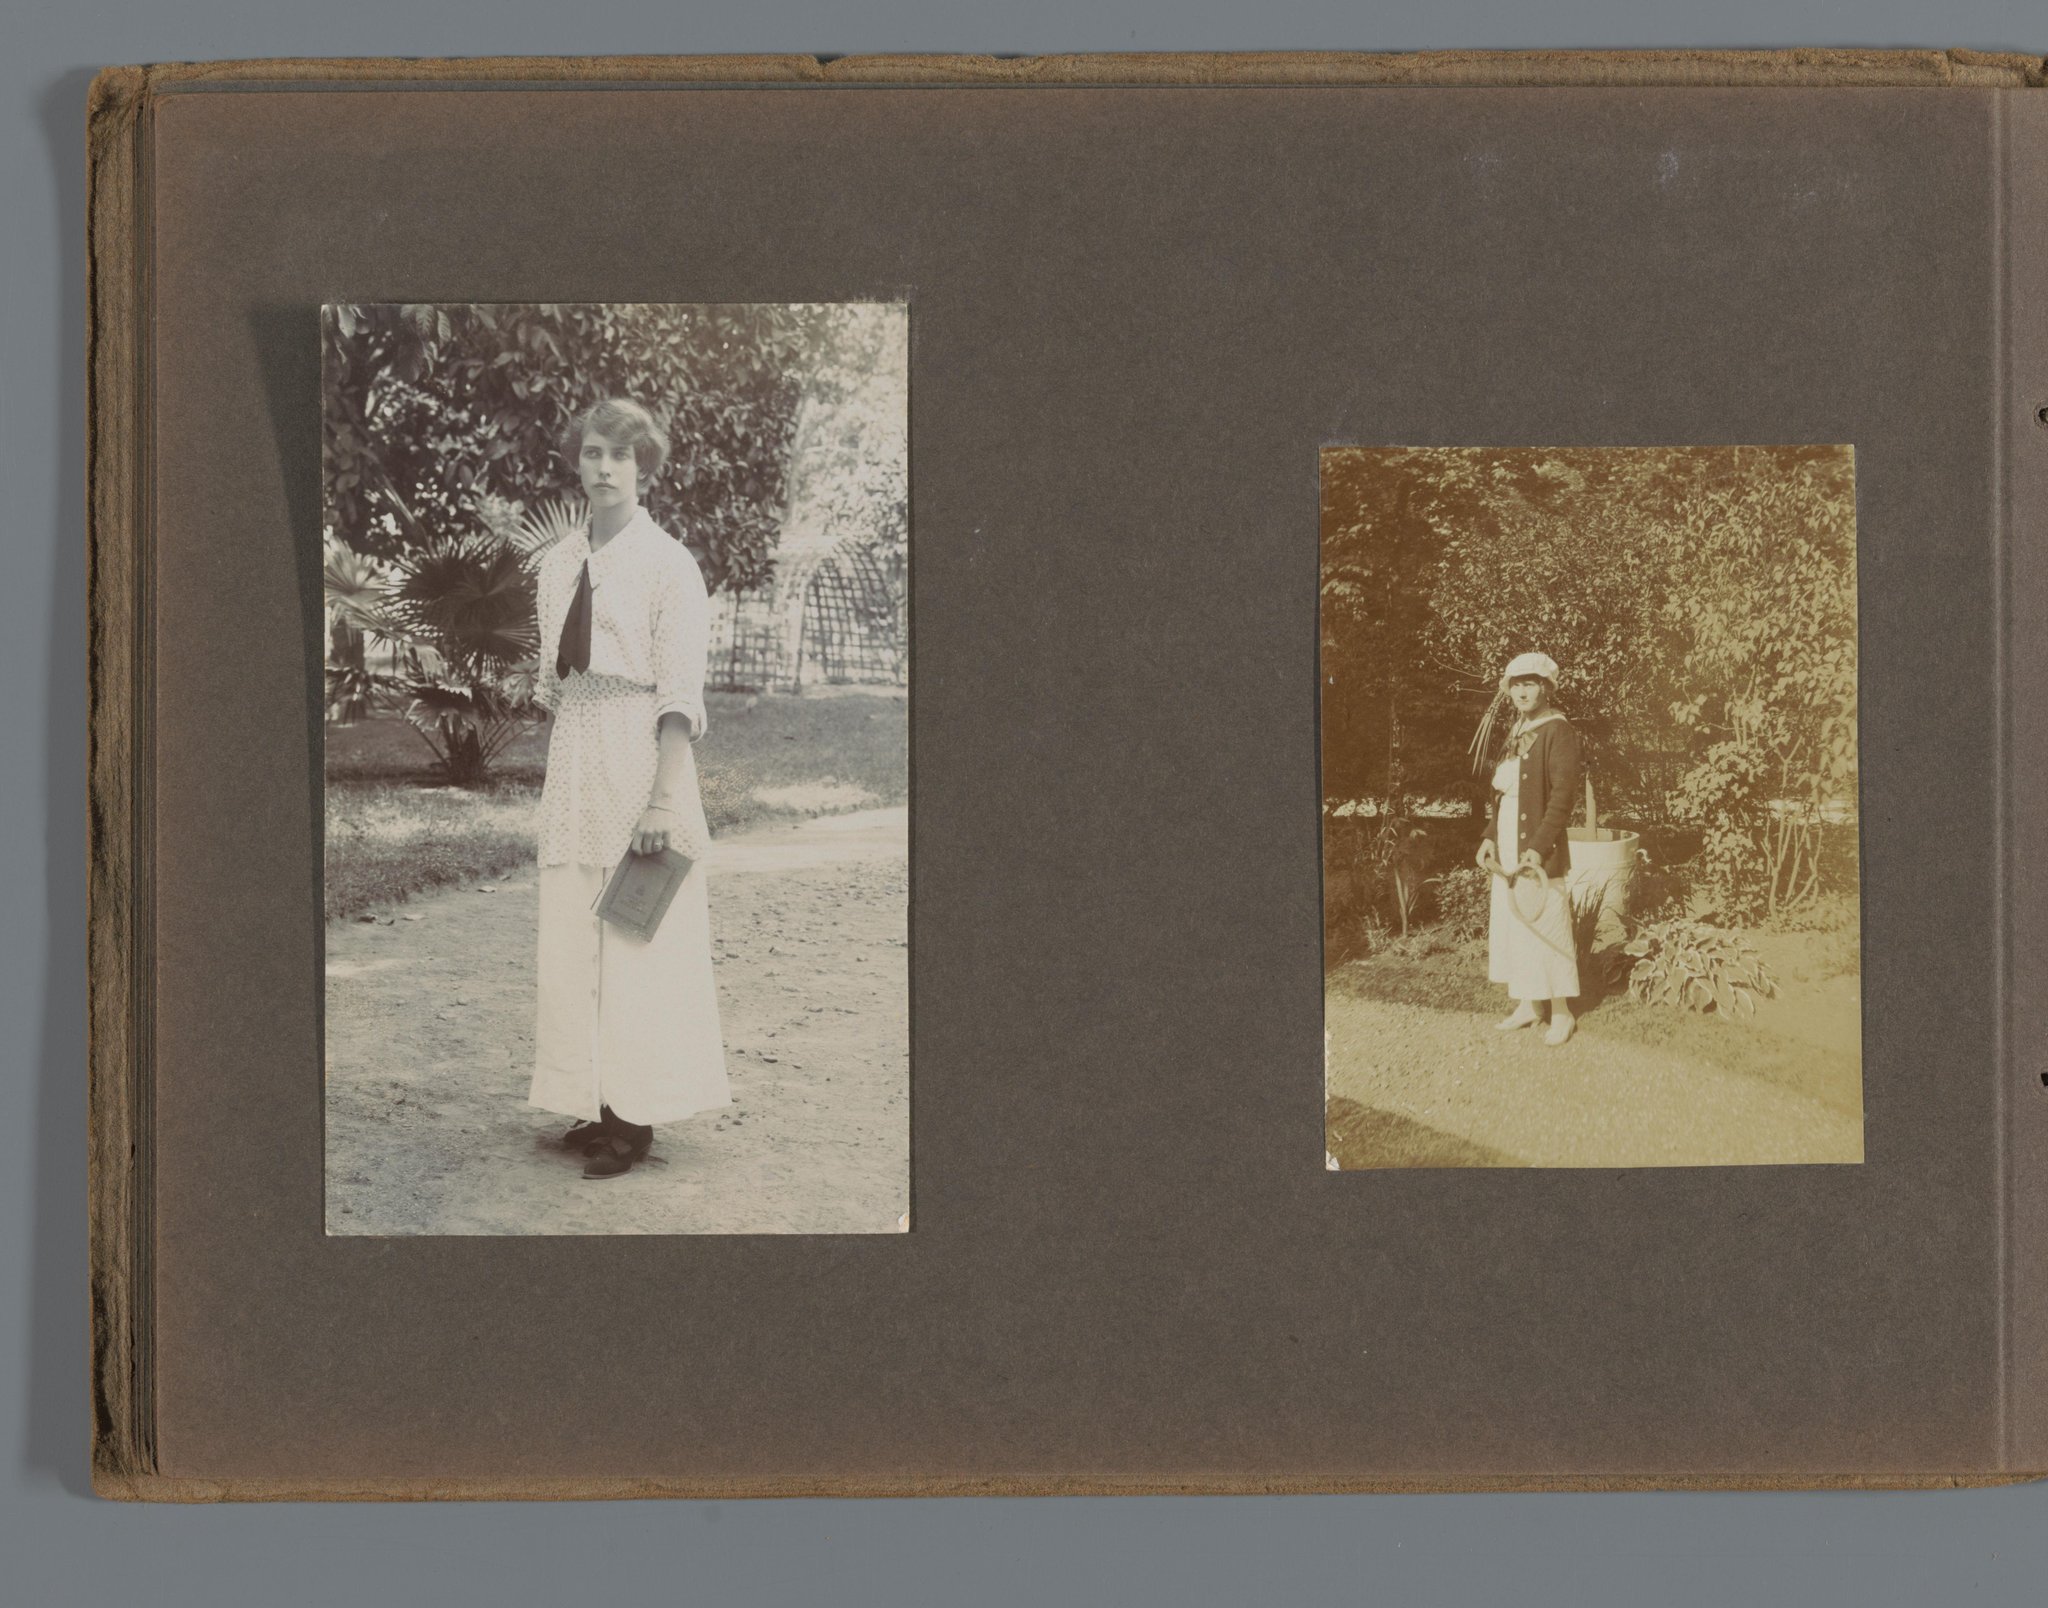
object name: album leaf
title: Twee onbekende jonge vrouwen in een tuin, links vermoedelijk in Nederlands-Indië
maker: carolina frederika onnen (lien/loen)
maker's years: 1896-1983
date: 1914-1915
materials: paper, cardboard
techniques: gelatin silver print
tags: anonymous historical person portrayed - bb - woman, dutch east indies, the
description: Deze foto's zijn onderdeel van een album.